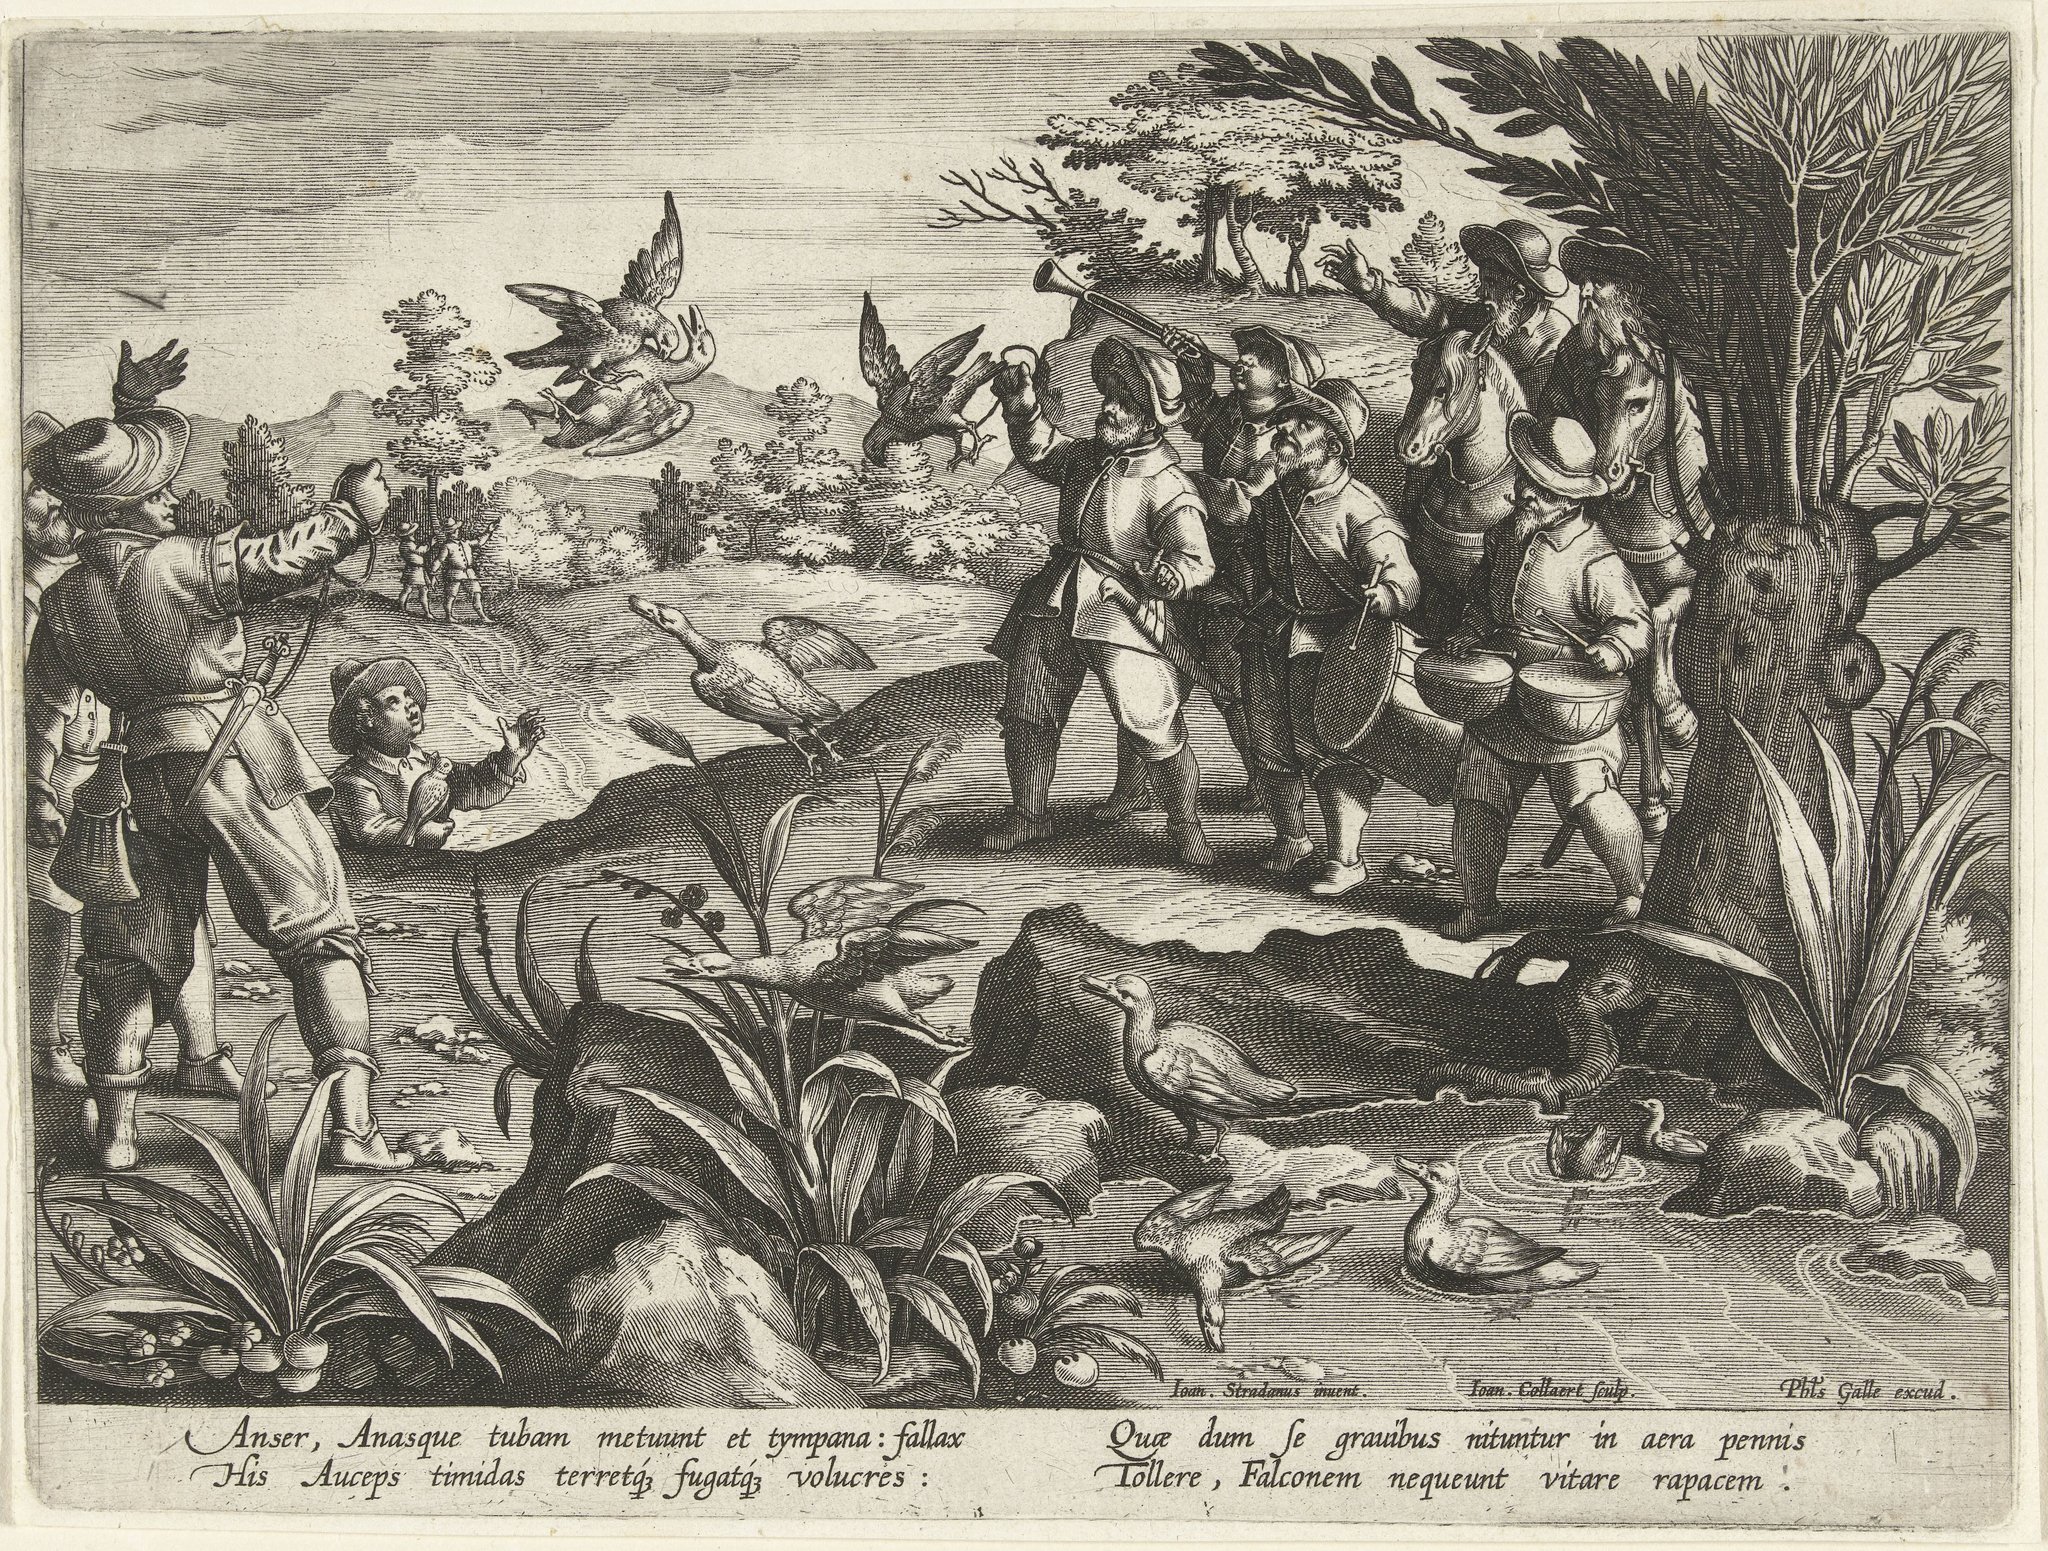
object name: print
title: Jachttaferelen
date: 1594-1598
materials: paper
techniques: engraving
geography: antwerp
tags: bird hunting (+ hunting with birds), water-birds: duck, brass band, street band - cc - out of doors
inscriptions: collector's mark: Lugt 240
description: Bij een kleine vijver wordt jacht gemaakt op eenden en ganzen. De vogels worden door muziek opgeschrikt en bang gemaakt, zodat ze een gemakkelijke prooi zijn voor een jachtvalk. De prent heeft een Latijns onderschrift en is deel van een serie over jachttaferelen.